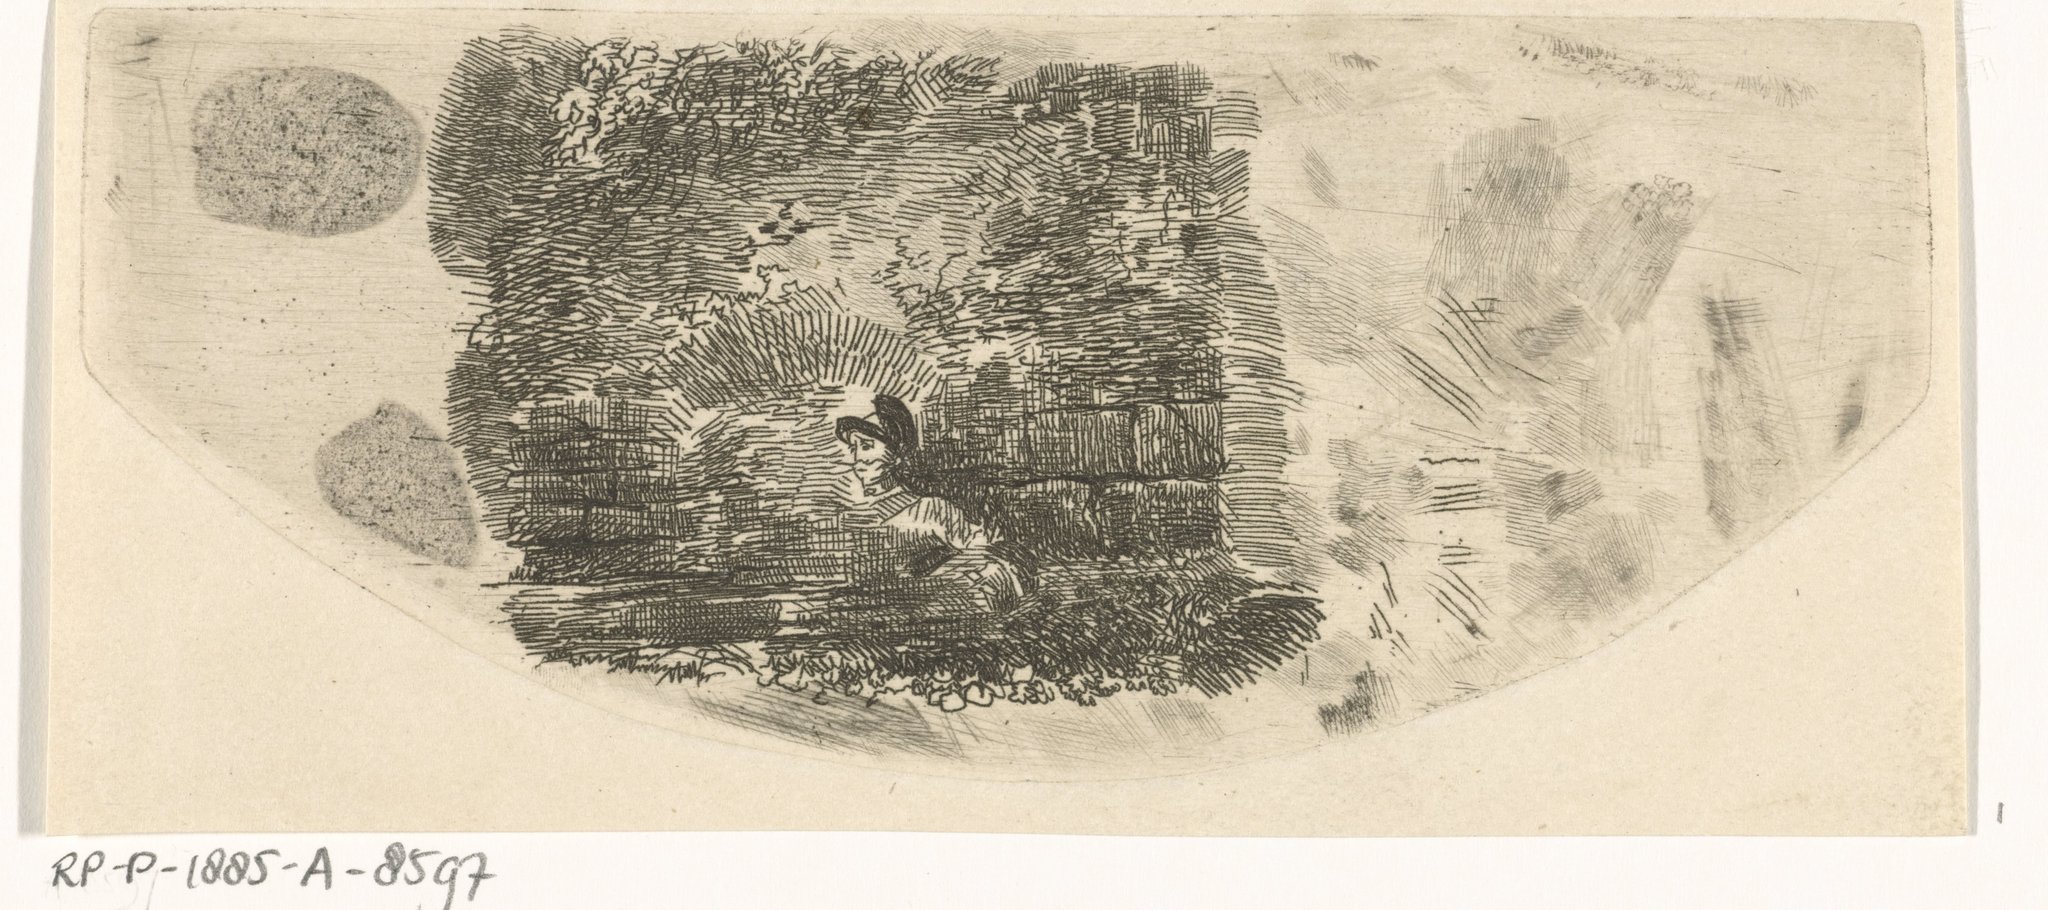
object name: print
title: Muur en het gezicht van een man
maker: johannes mock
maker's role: draughtsman, painter, print maker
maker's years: 1800-1884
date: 1810-1884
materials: paper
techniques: etching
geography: netherlands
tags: head (human), fence, wall, paling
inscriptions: collector's mark: Lugt 2228, inscription: ‘Proef welke gedurende 6 uren gebeten heeft zonder wegstopping ...gewoon water.’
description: Studieblad met een muur en daarvoor het gezicht van een man. Links en rechts etsoefeningen.